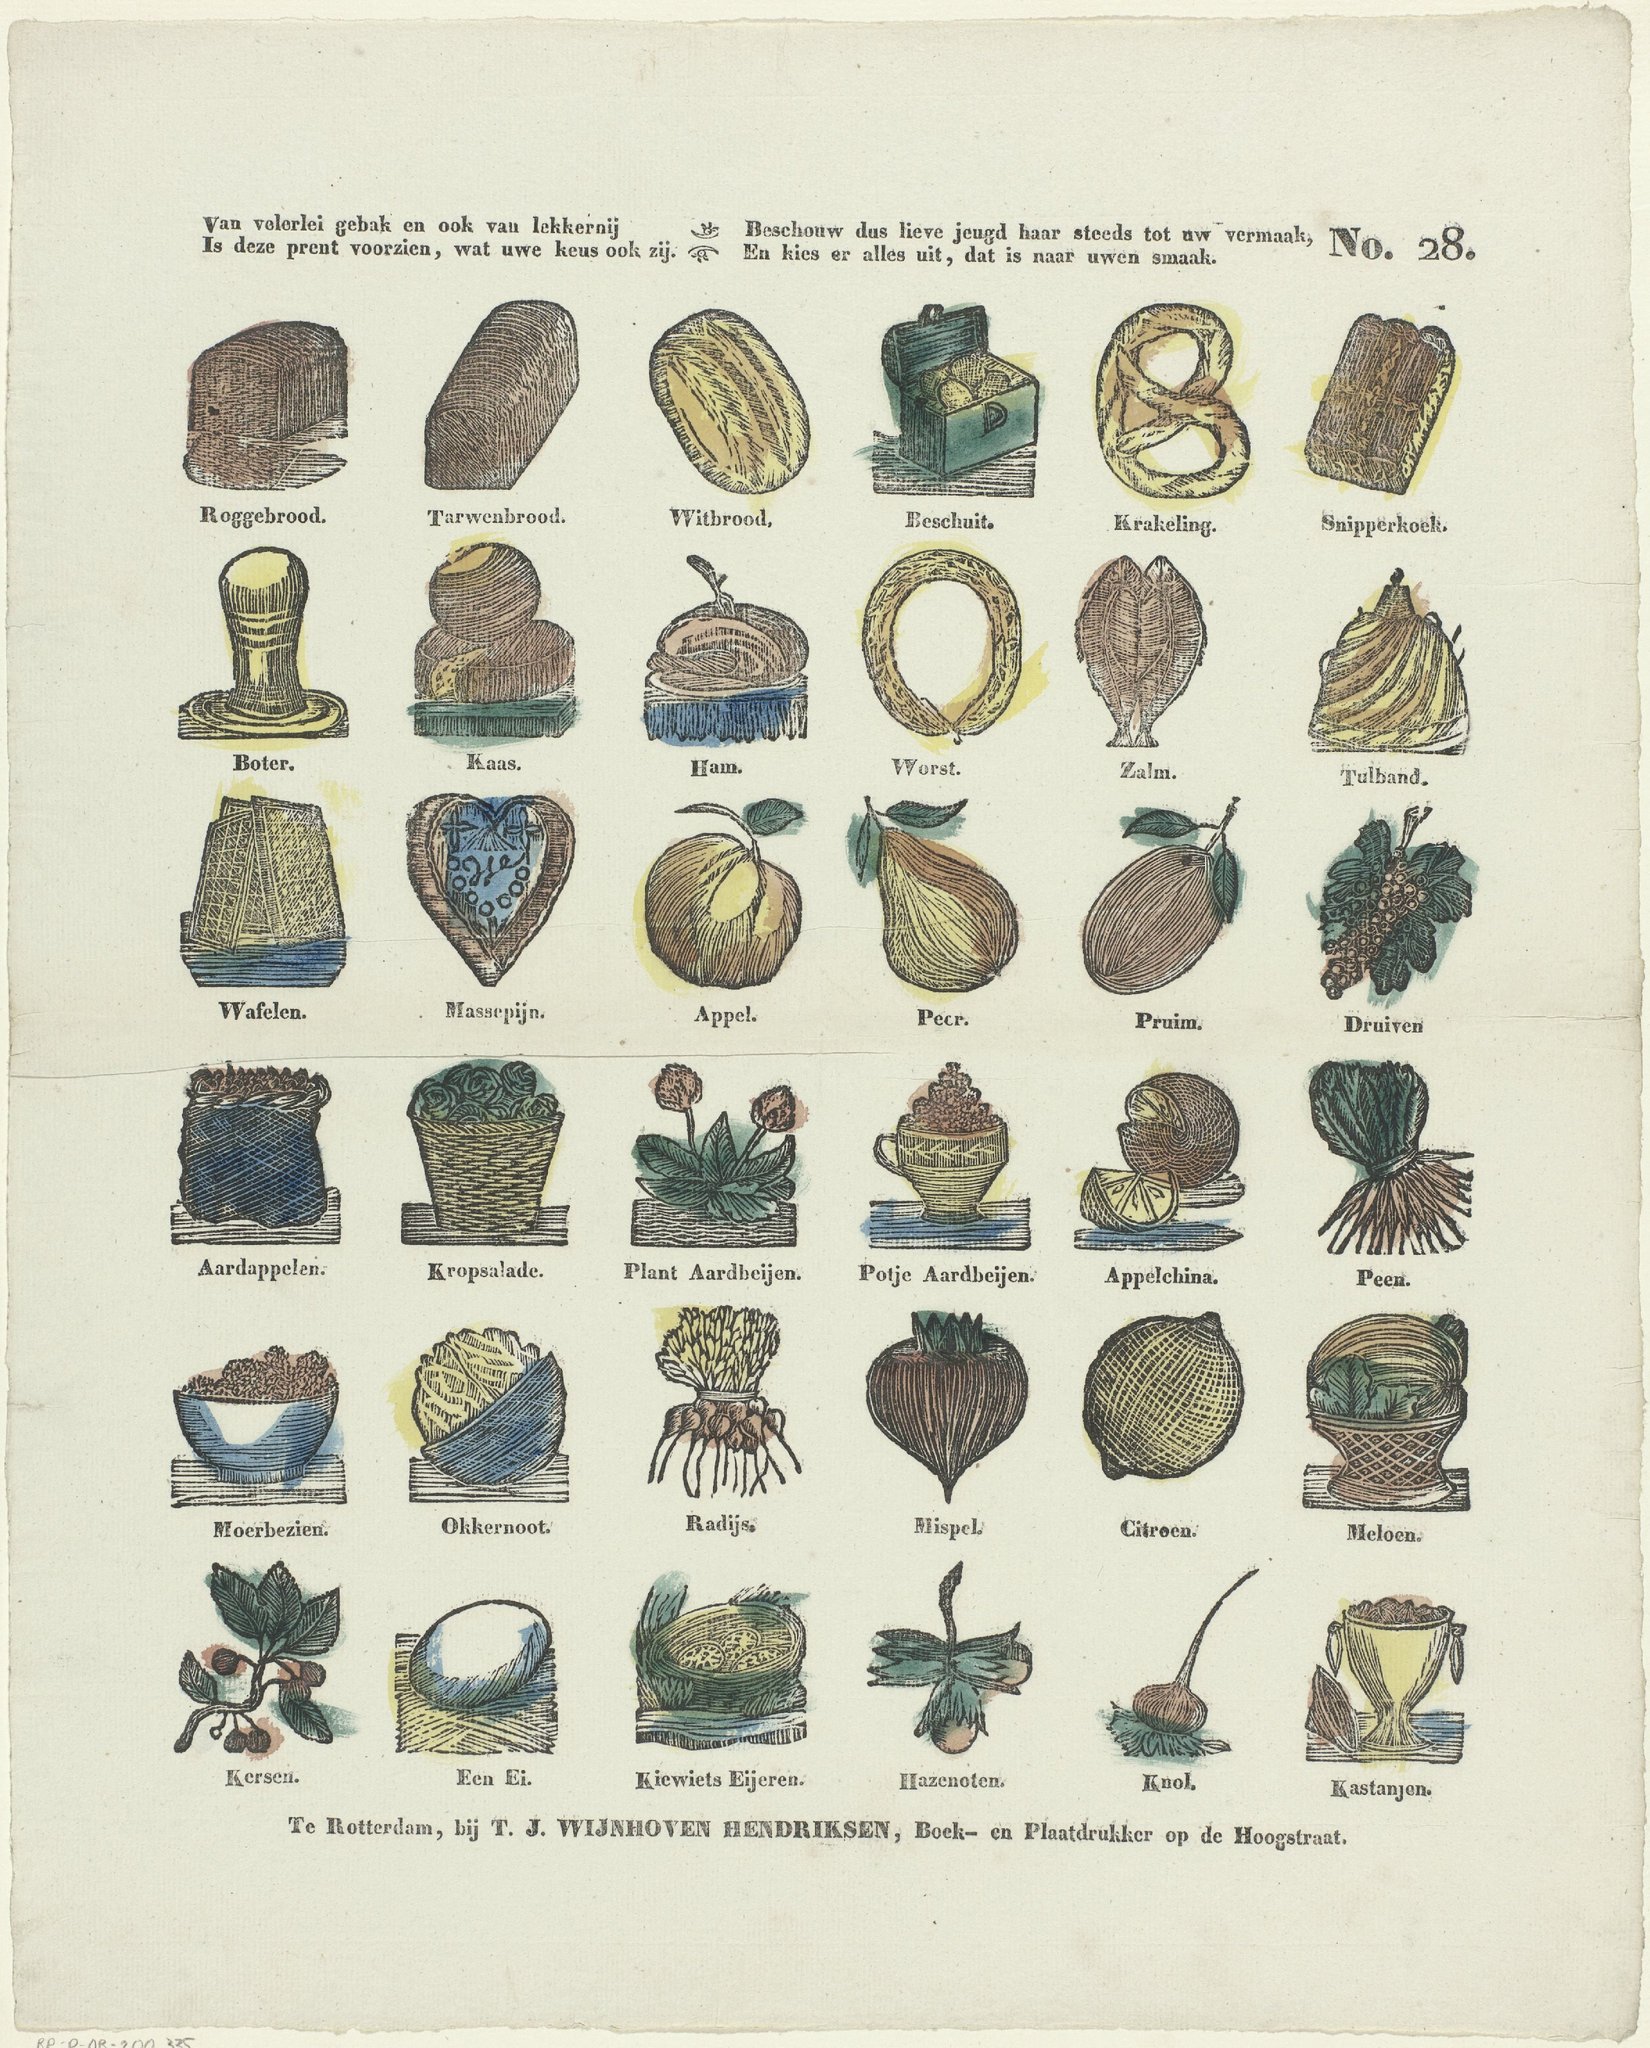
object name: print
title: Van velerlei gebak en ook van lekkernij / Is deze prent voorzien, wat uwe keus ook zij. / Beschouw dus lieve jeugd haar steeds tot uw vermaak, / En kies er alles uit, dat is naar uwen smaak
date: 1832-1850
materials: paper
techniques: colour, letterpress printing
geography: rotterdam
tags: vegetables, cake, tart, pastry, bread, loaf, fruits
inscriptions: collector's mark: Lugt 2760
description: Blad met 36 voorstellingen van etenswaren, zoals roggebrood, zalm, peer en knol. Onder elke voorstelling een onderschrift. Genummerd rechtsboven: No. 28.